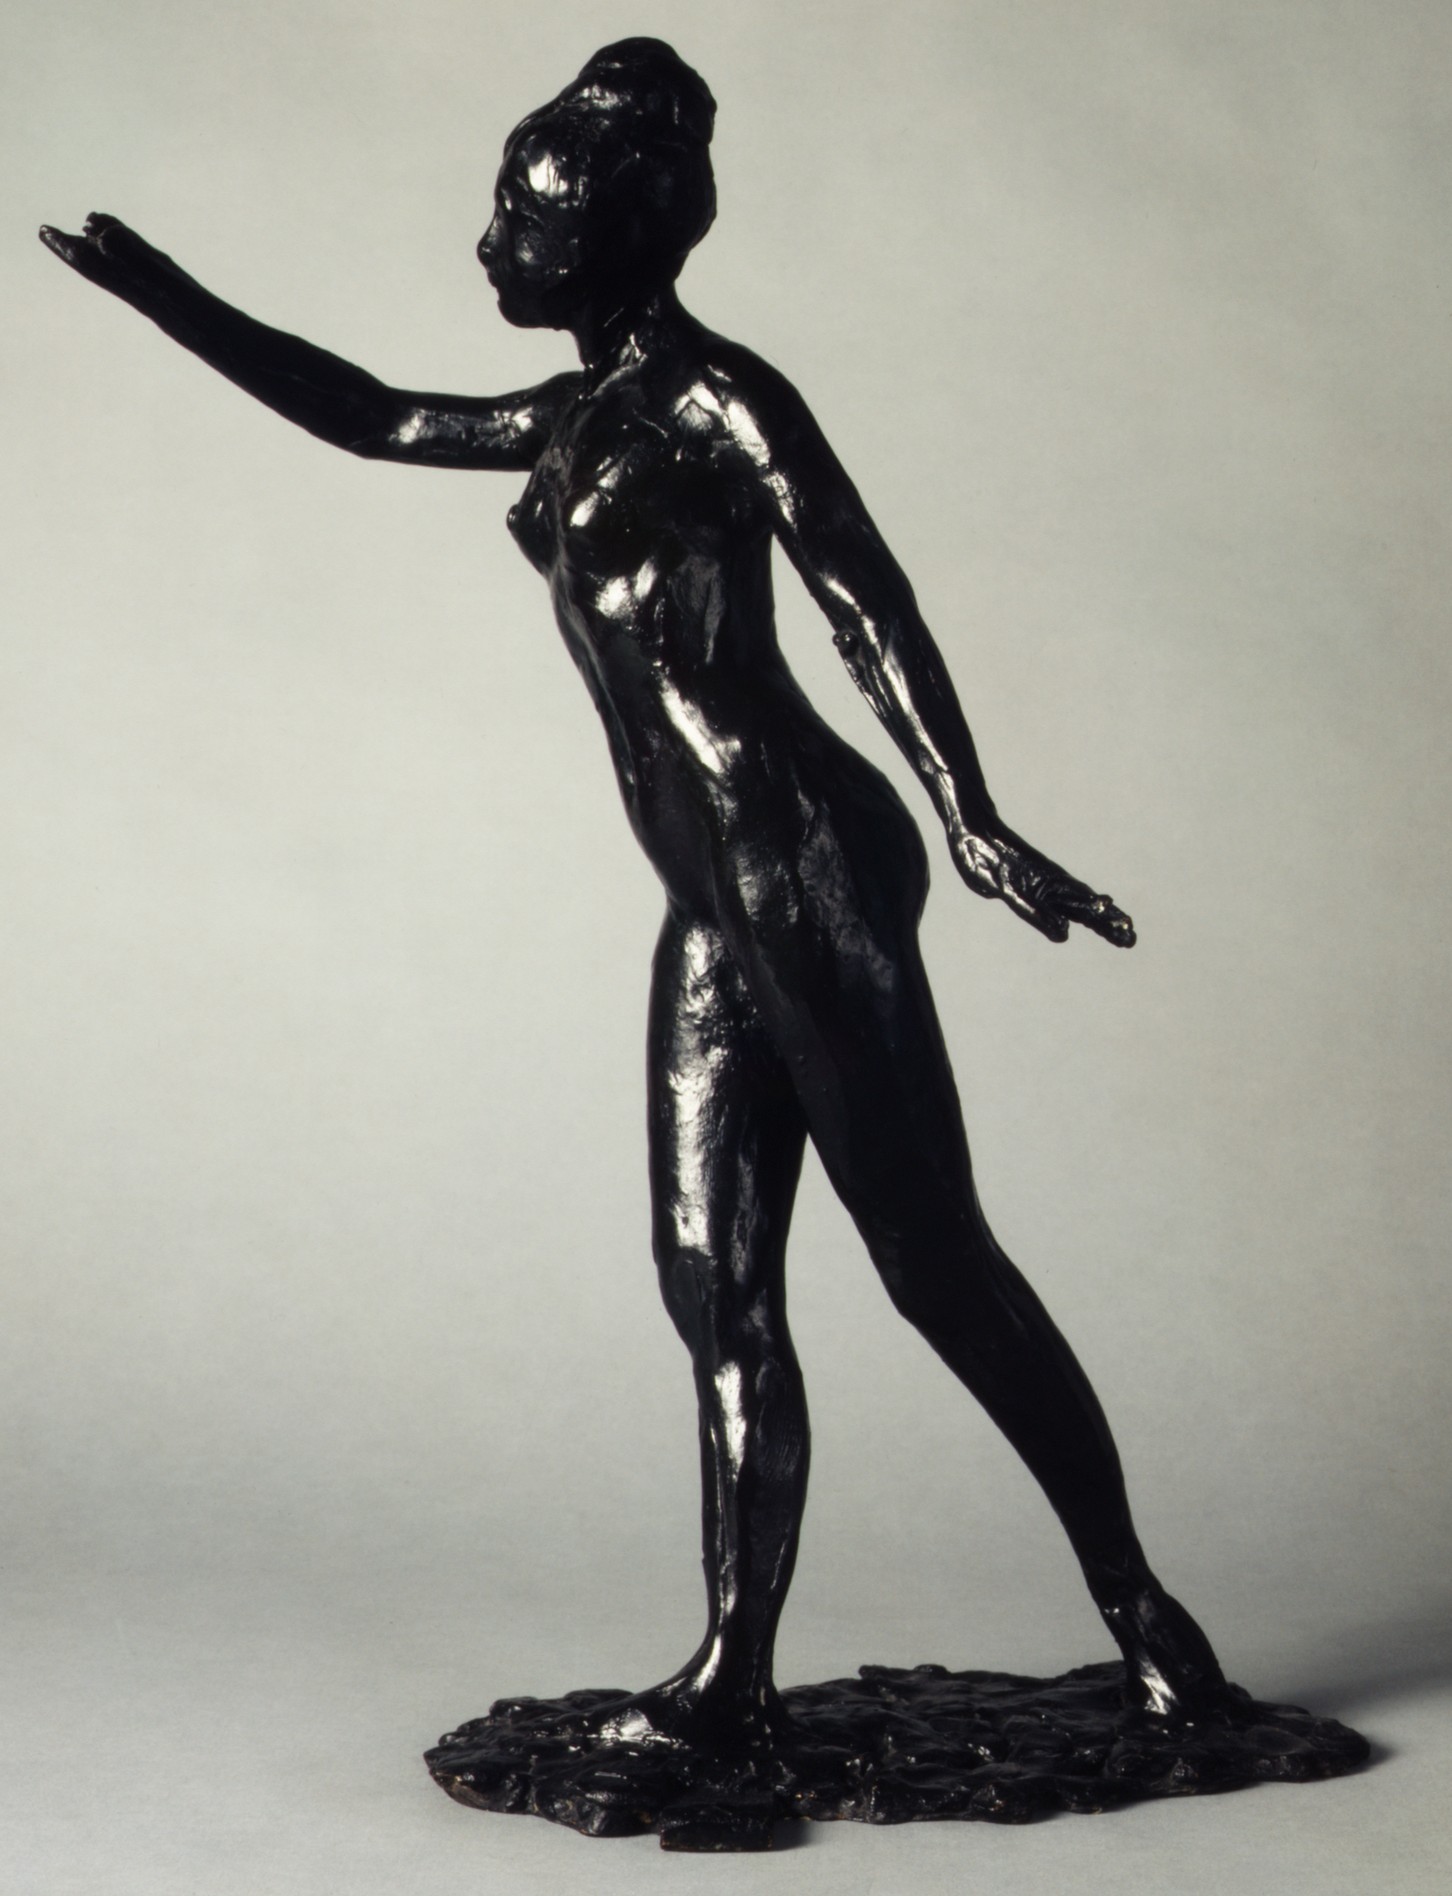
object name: statuette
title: Tendu Derrière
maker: edgar degas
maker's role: artist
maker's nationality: french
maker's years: 1834-1917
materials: bronze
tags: female nudes,dancers,ballet